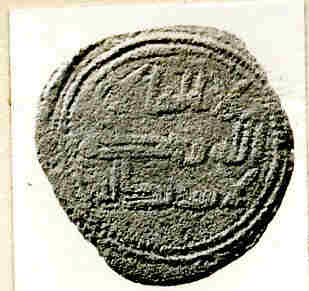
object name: coin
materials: copper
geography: iran